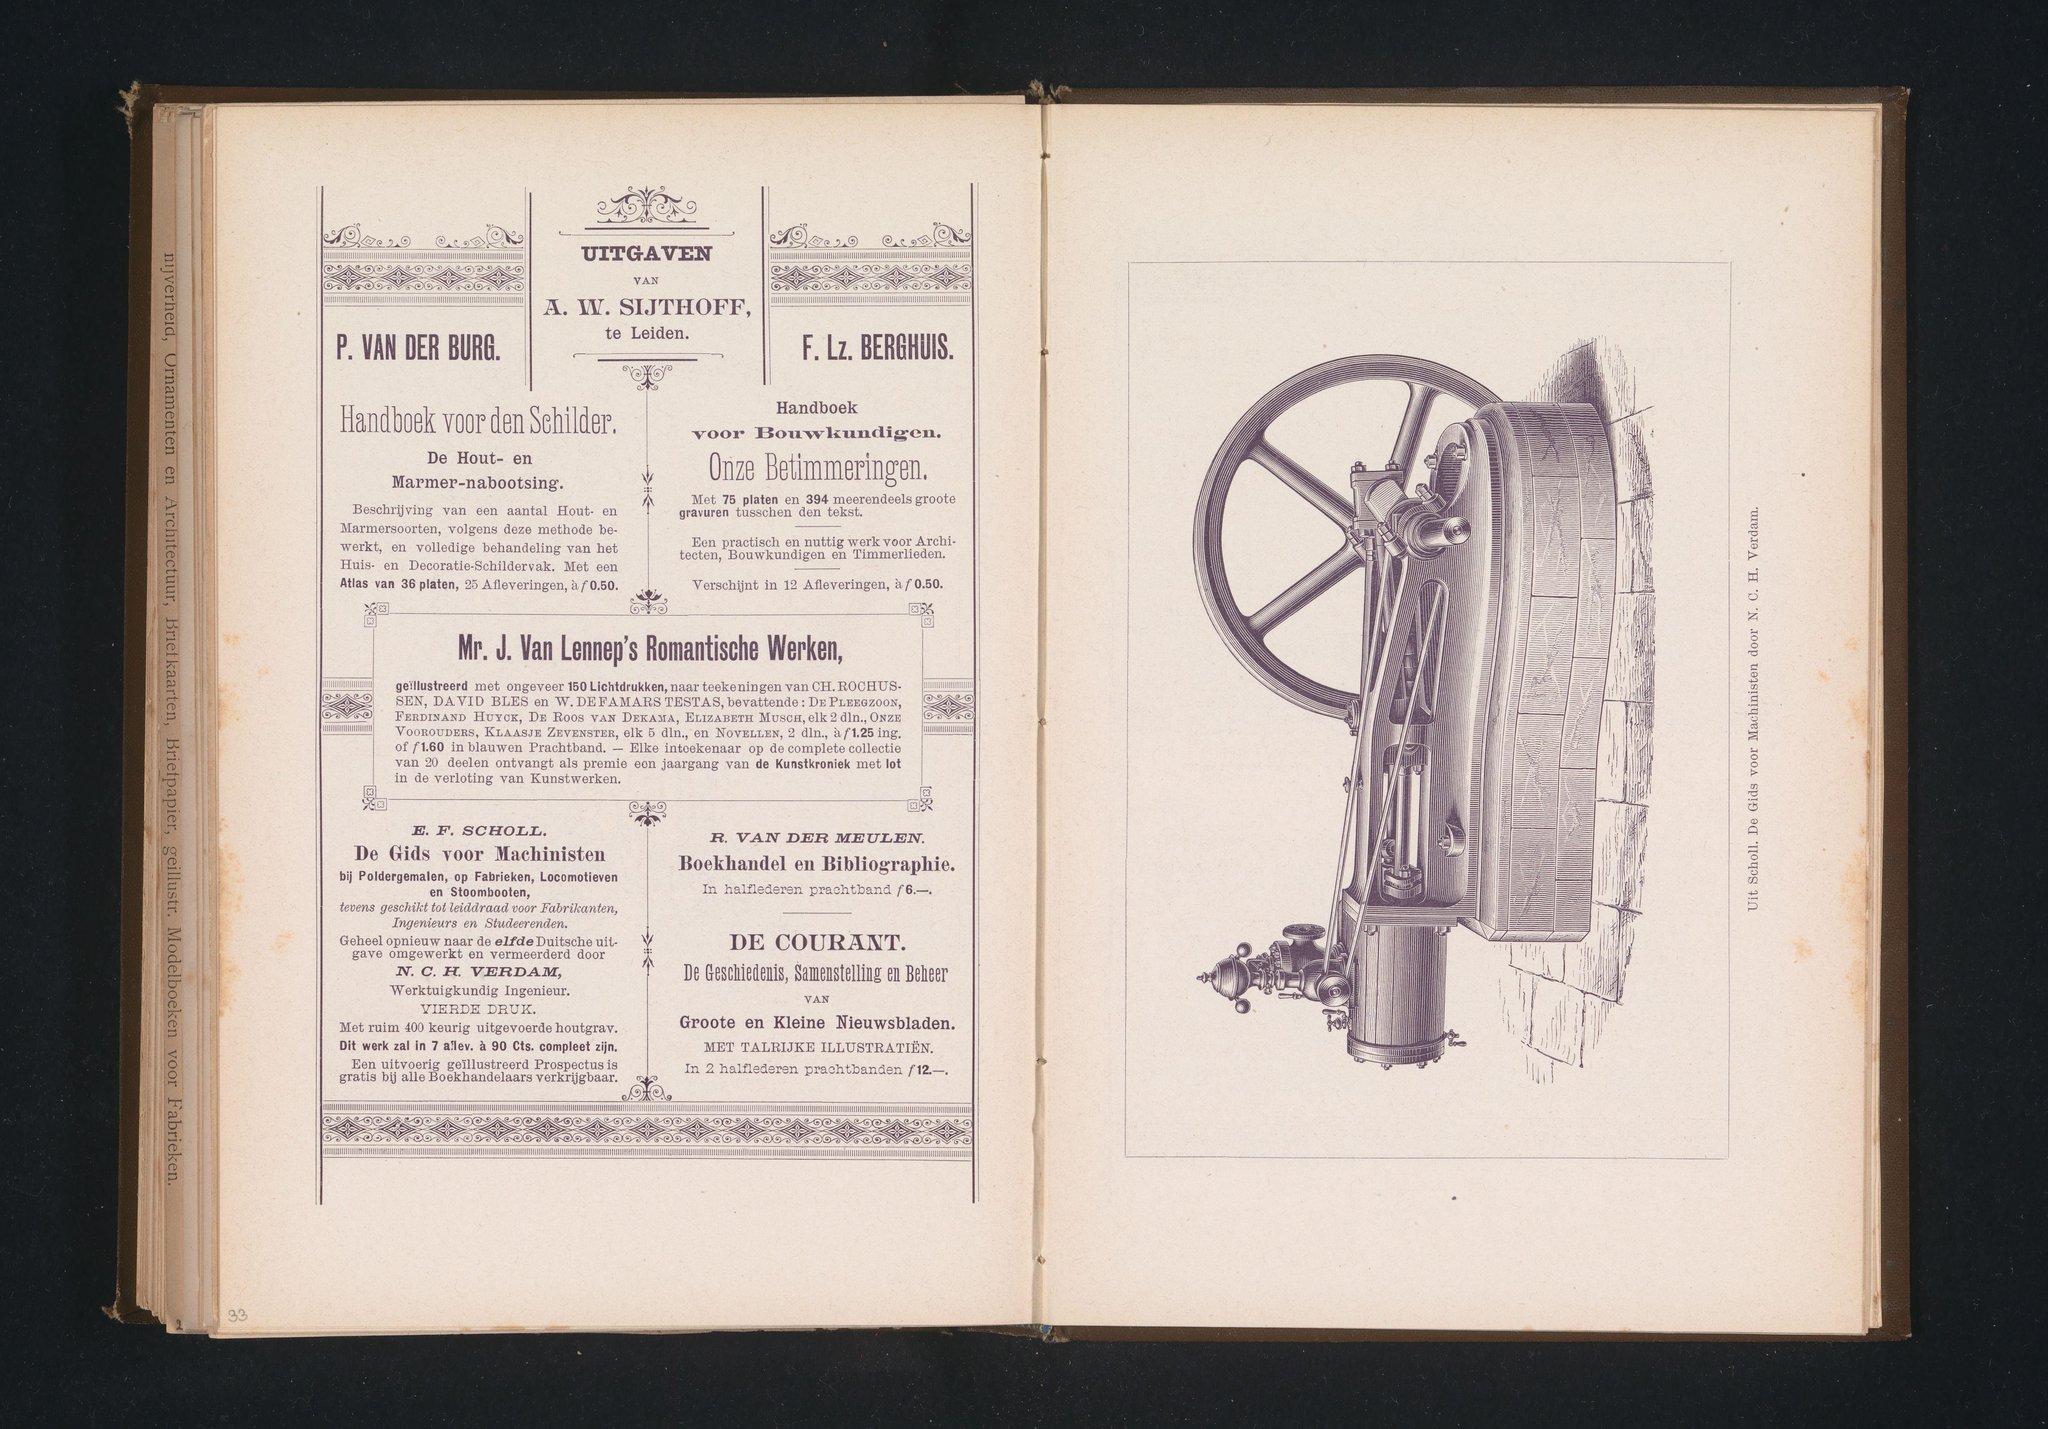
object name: reproduction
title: Reproductie van een gravure van een machine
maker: Anonymous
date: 1887-1892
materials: paper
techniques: printing block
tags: machines; parts of machines; tools and appliances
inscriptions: inscription: ‘Uit Scholl. De Gids voor Machinisten door N. C. H. Verdam.’